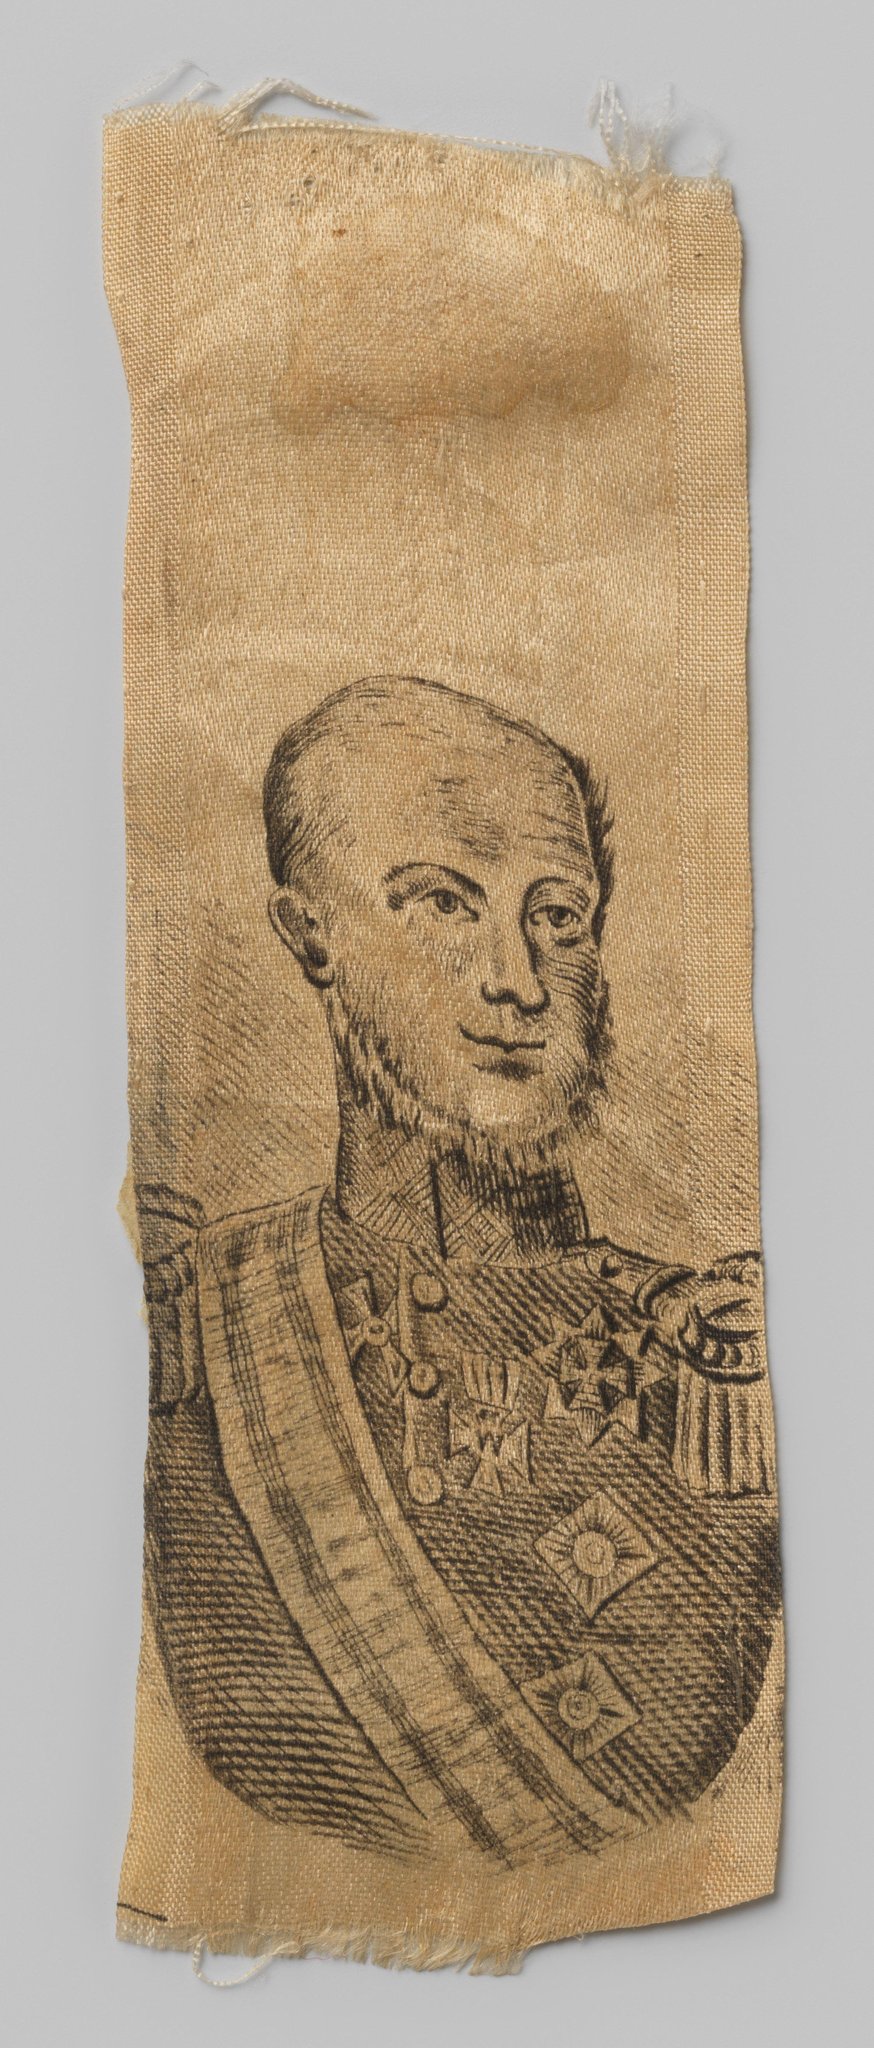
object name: ribbon material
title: Oranjelint Willem II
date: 1840-1849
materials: silk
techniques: printing, weave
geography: netherlands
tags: the hague, william ii of the netherlands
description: Oranje lint waarop in het zwart het borststuk van een kalende man met ringbaard en in uniform (Willem II) is gedrukt.